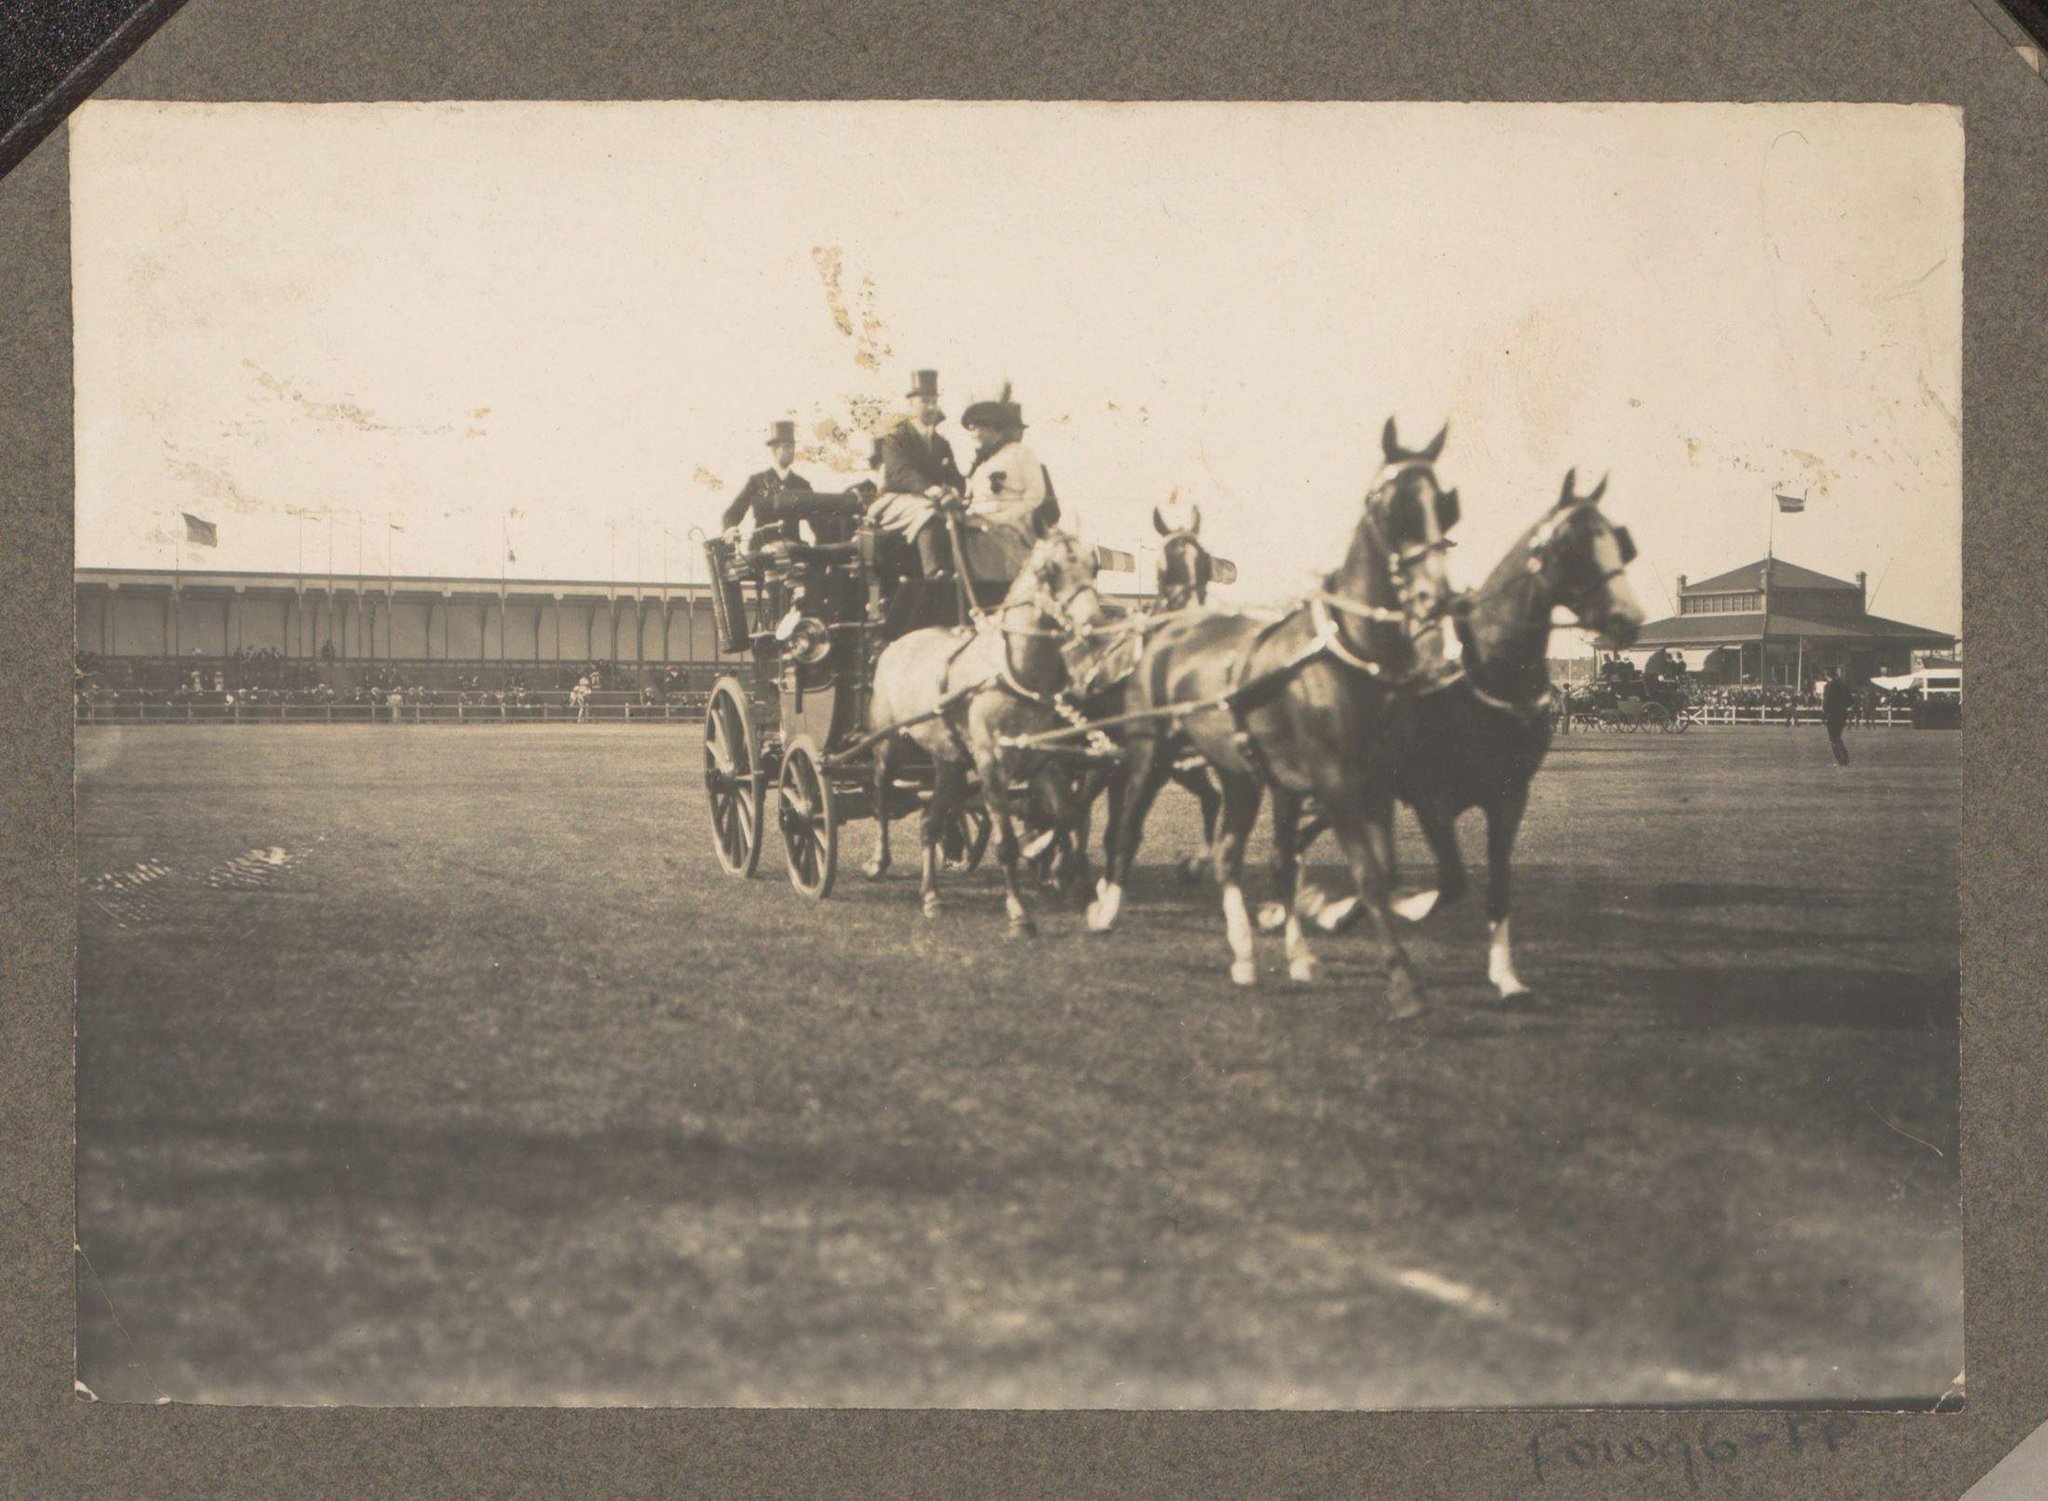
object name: album leaf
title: Vierspan van stalhouderij Van der Kuylen met koetsier Rikkers en Nederlands gefokte paarden tijdens de eerste marathon van Nederland op Houtrust, Den Haag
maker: Anonymous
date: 1914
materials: photographic support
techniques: gelatin silver print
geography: the hague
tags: hunting, chase, hunting-ground, horse-racing, four-wheeled vehicle drawn by more than three animals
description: Onderdeel van Fotoalbum van de heer Brams, opperhoutvester van koningin Wilhelmina op Koninklijke Houtvesterij Het Loo.